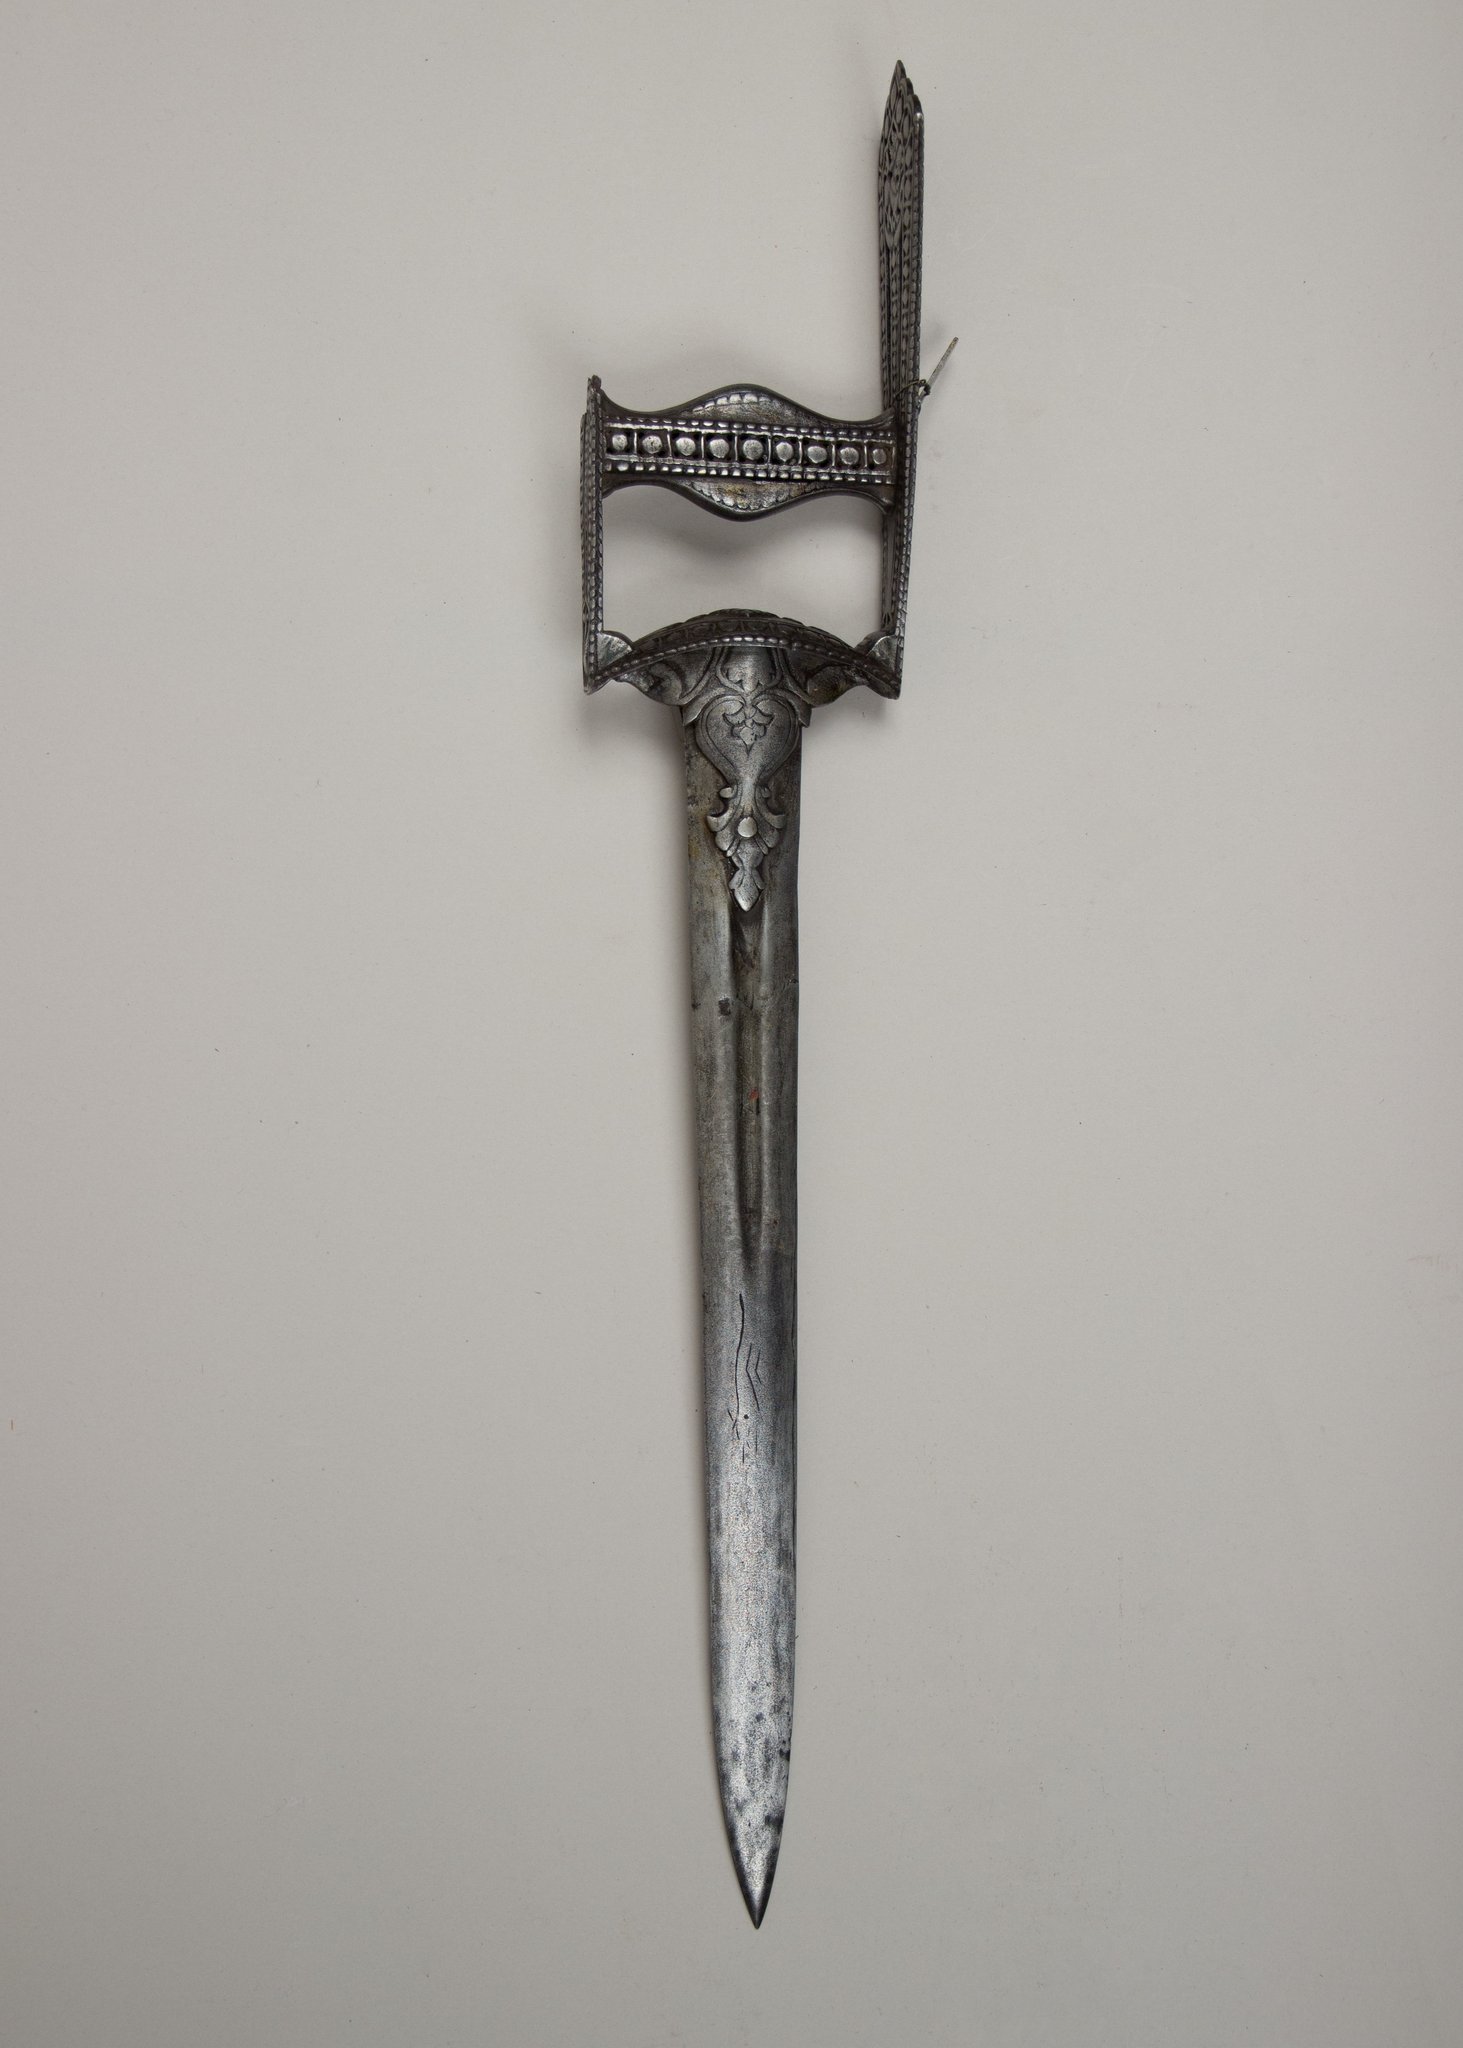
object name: dagger katar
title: Dagger (Katar)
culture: european or south indian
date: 1701-1900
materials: steel